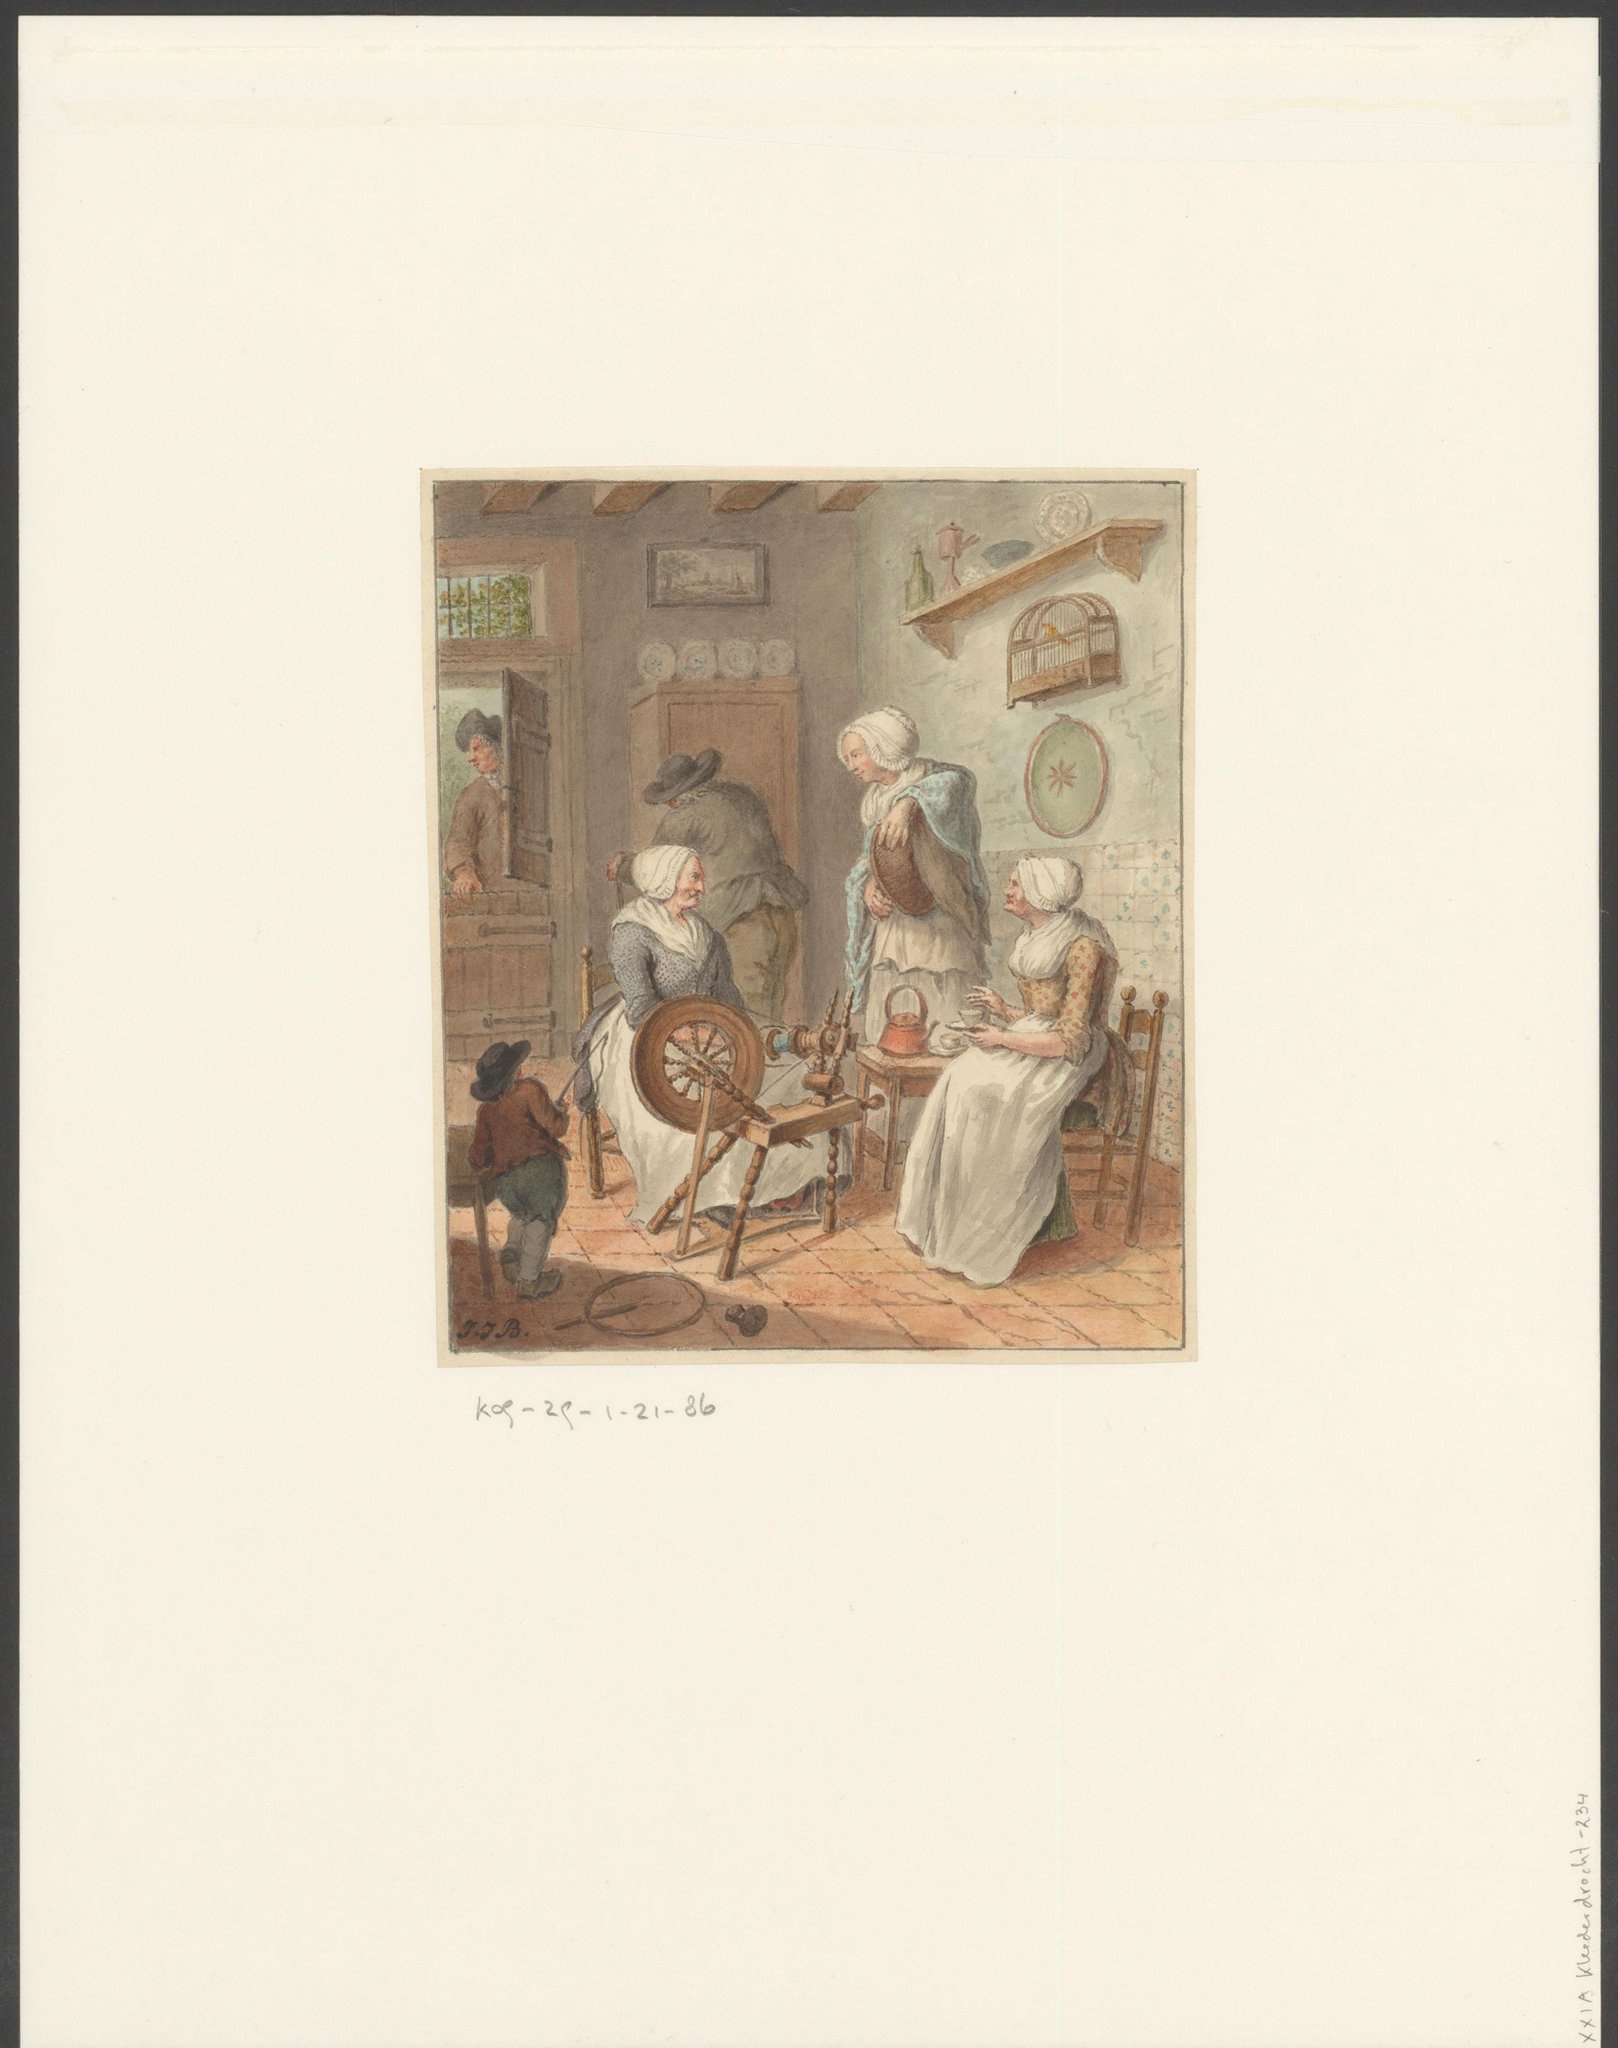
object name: drawing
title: Huiskamer met drie vrouwen een man en een kind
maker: joannis jacobus bijlaert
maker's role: draughtsman, print maker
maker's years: 1734-1809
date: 1744-1809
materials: paper, watercolor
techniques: brush, pen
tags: adult woman, old man, old woman, living-room, parlour, sitting-room, bird in a cage, spinning (manufacture of yarn)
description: Huiskamer met drie vrouwen een man en een kind. Een vrouw zit aan een spinnewiel en een andere vrouw aan een tafel met een kop thee of koffie. Linksonder is een kind met hengel op de rug gezien. Achter in de kamer staat een oude man met stok bij een kast. Door een open luik is een tweede man gezien. Onderwerpsrubrieken binnen de Atlas Zeden en Gewoonten: Zeden en Gewoonten in Engeren Zin, De Kleeding, Kleederdrachten (tijdvakken), De 18de eeuw (de pruikentijd). Mannen en vrouwen.